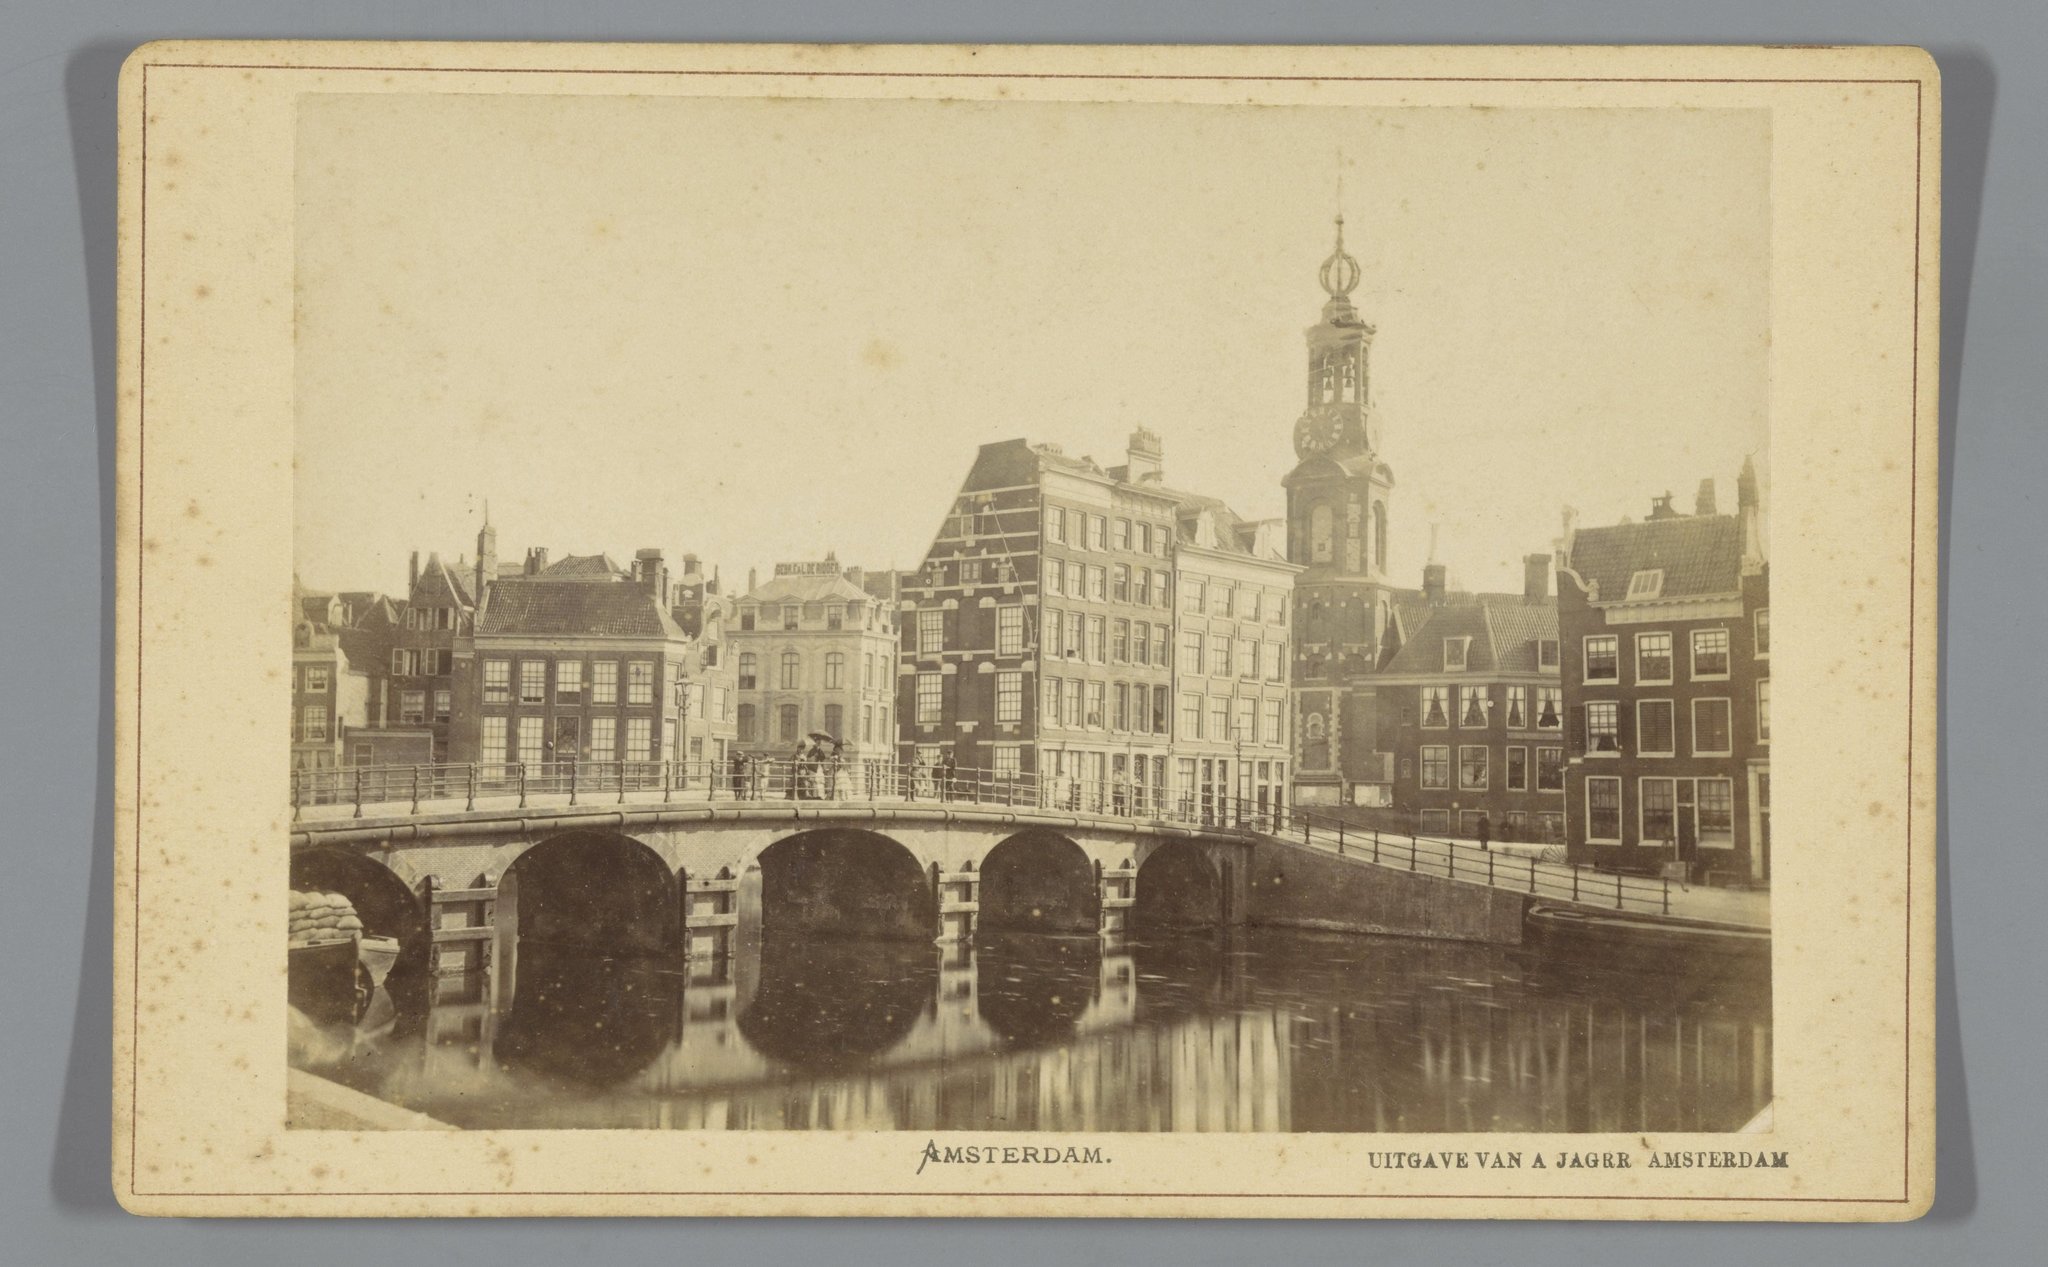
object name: cabinet photograph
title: Gezicht op het Schapenplein in Amsterdam, met op de achtergrond de Munttoren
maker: andries jager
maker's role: publisher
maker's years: 1825-1905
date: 1860-1890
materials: cardboard, photographic support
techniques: albumen print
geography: amsterdam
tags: tower, clock tower ~ monumental adornment, canals, waters (in city)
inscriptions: annotation: ‘Voormalig Schapenplein’